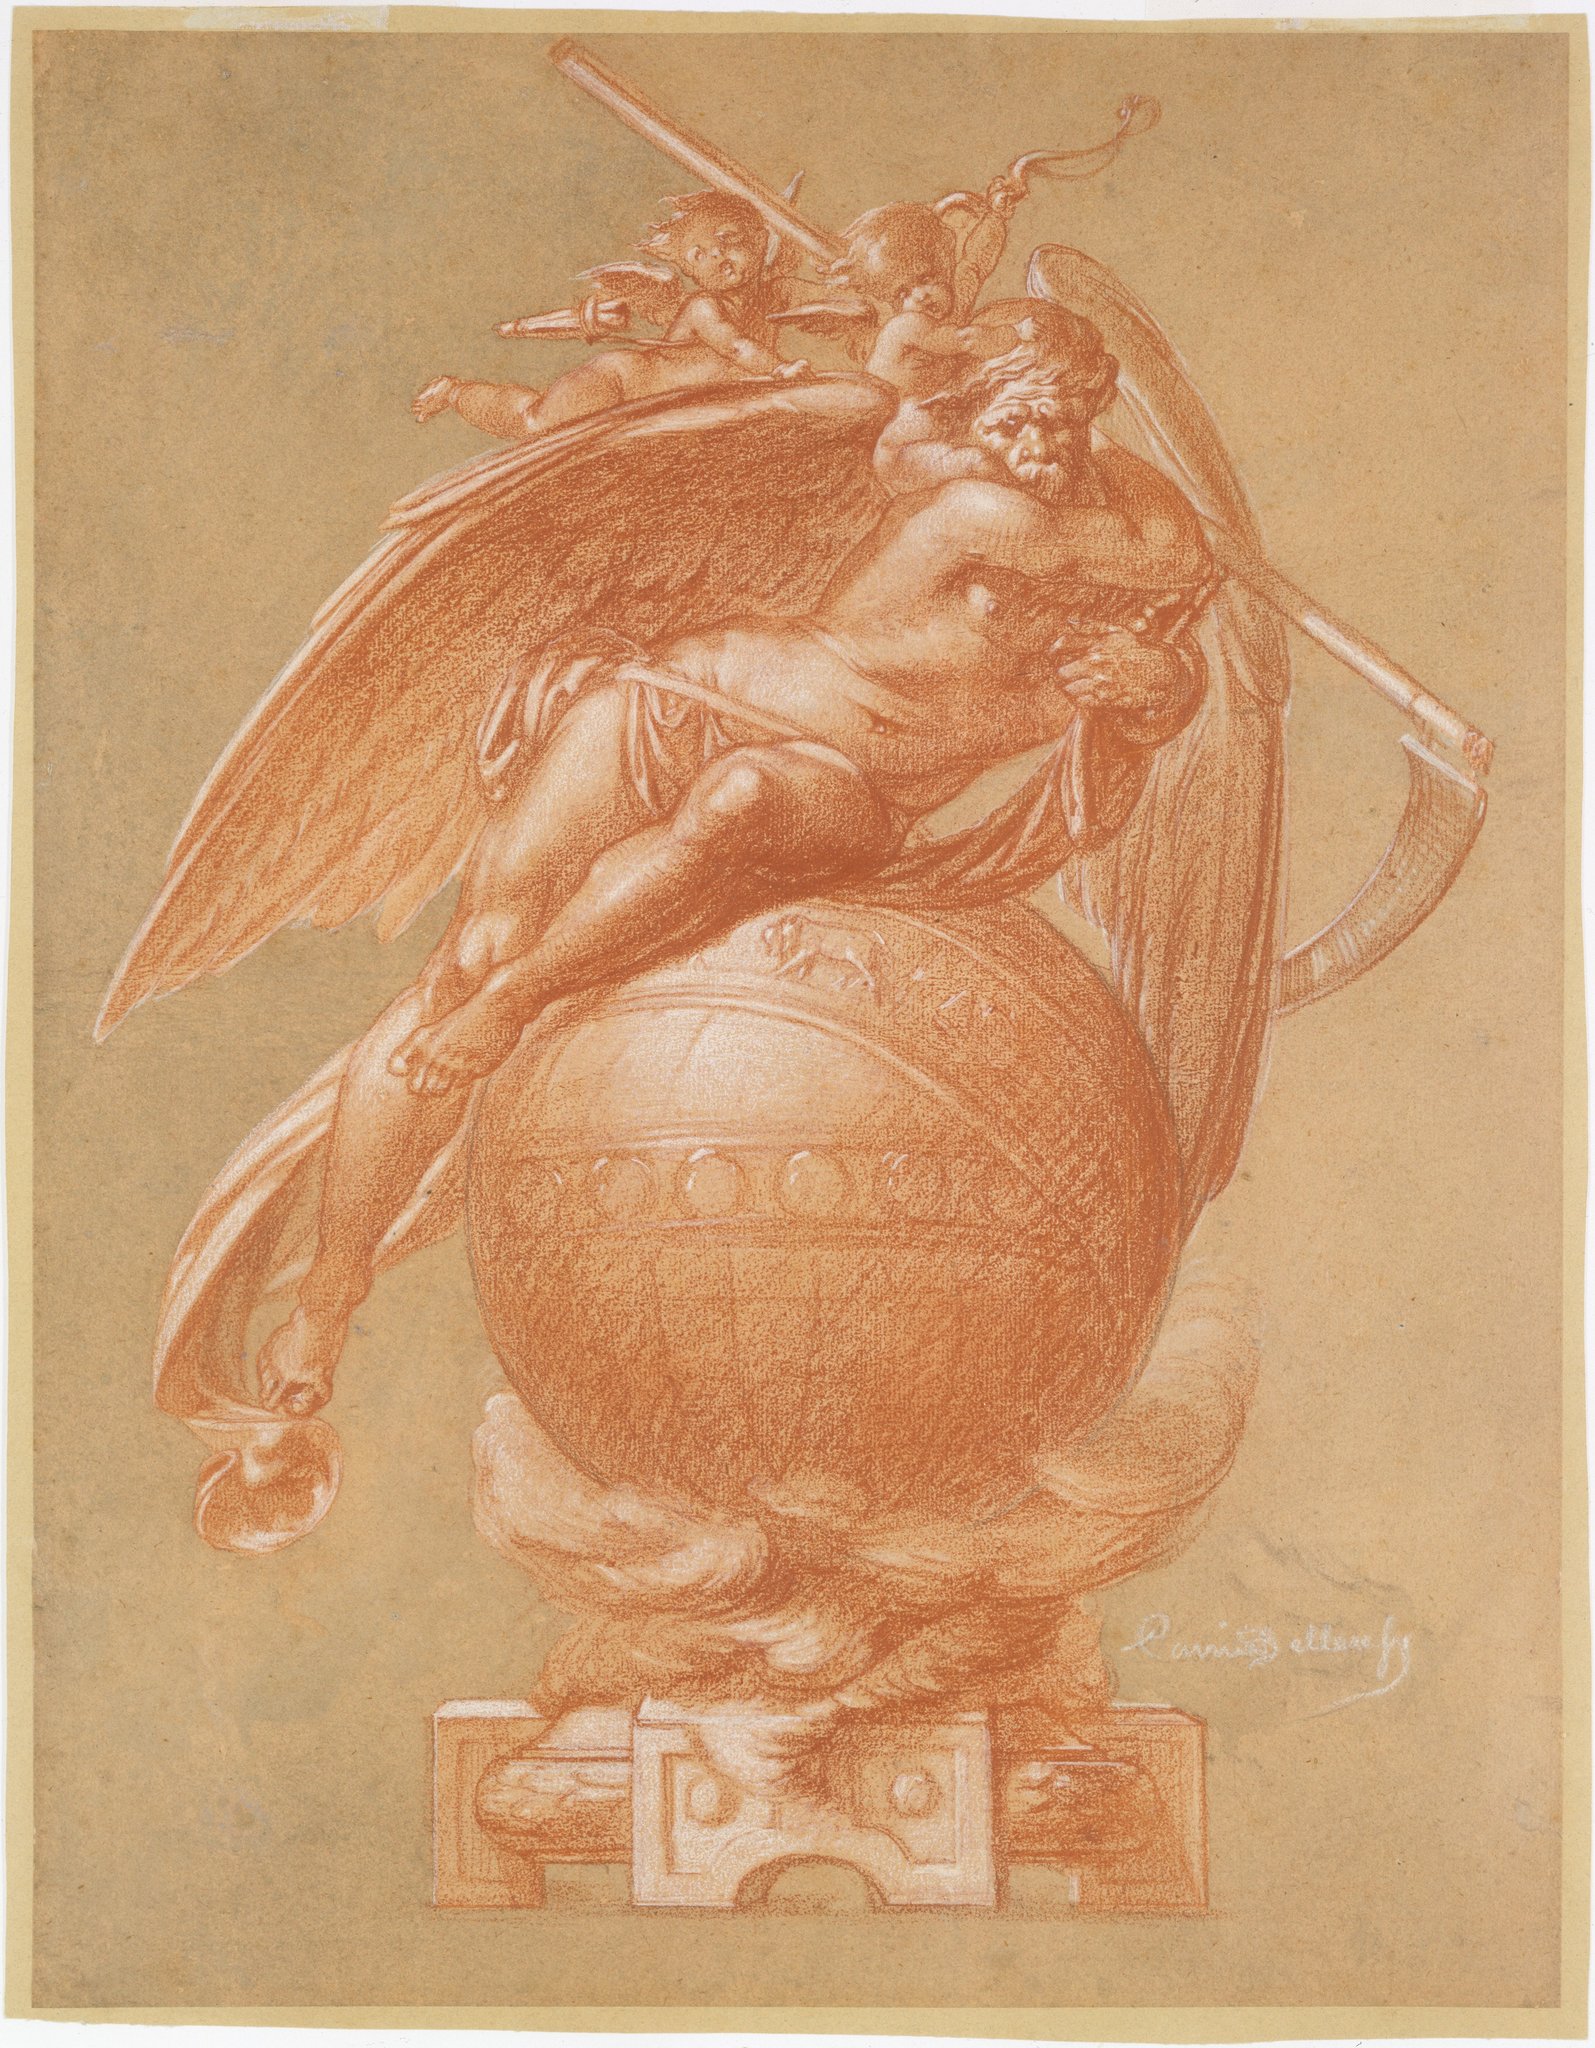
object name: drawing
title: Father Time on a Globe; Design for a Clock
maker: albert-ernest carrier-belleuse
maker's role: artist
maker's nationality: french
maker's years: 1824-1887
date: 1801-1900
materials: chalk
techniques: heightening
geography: france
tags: weapons,globes